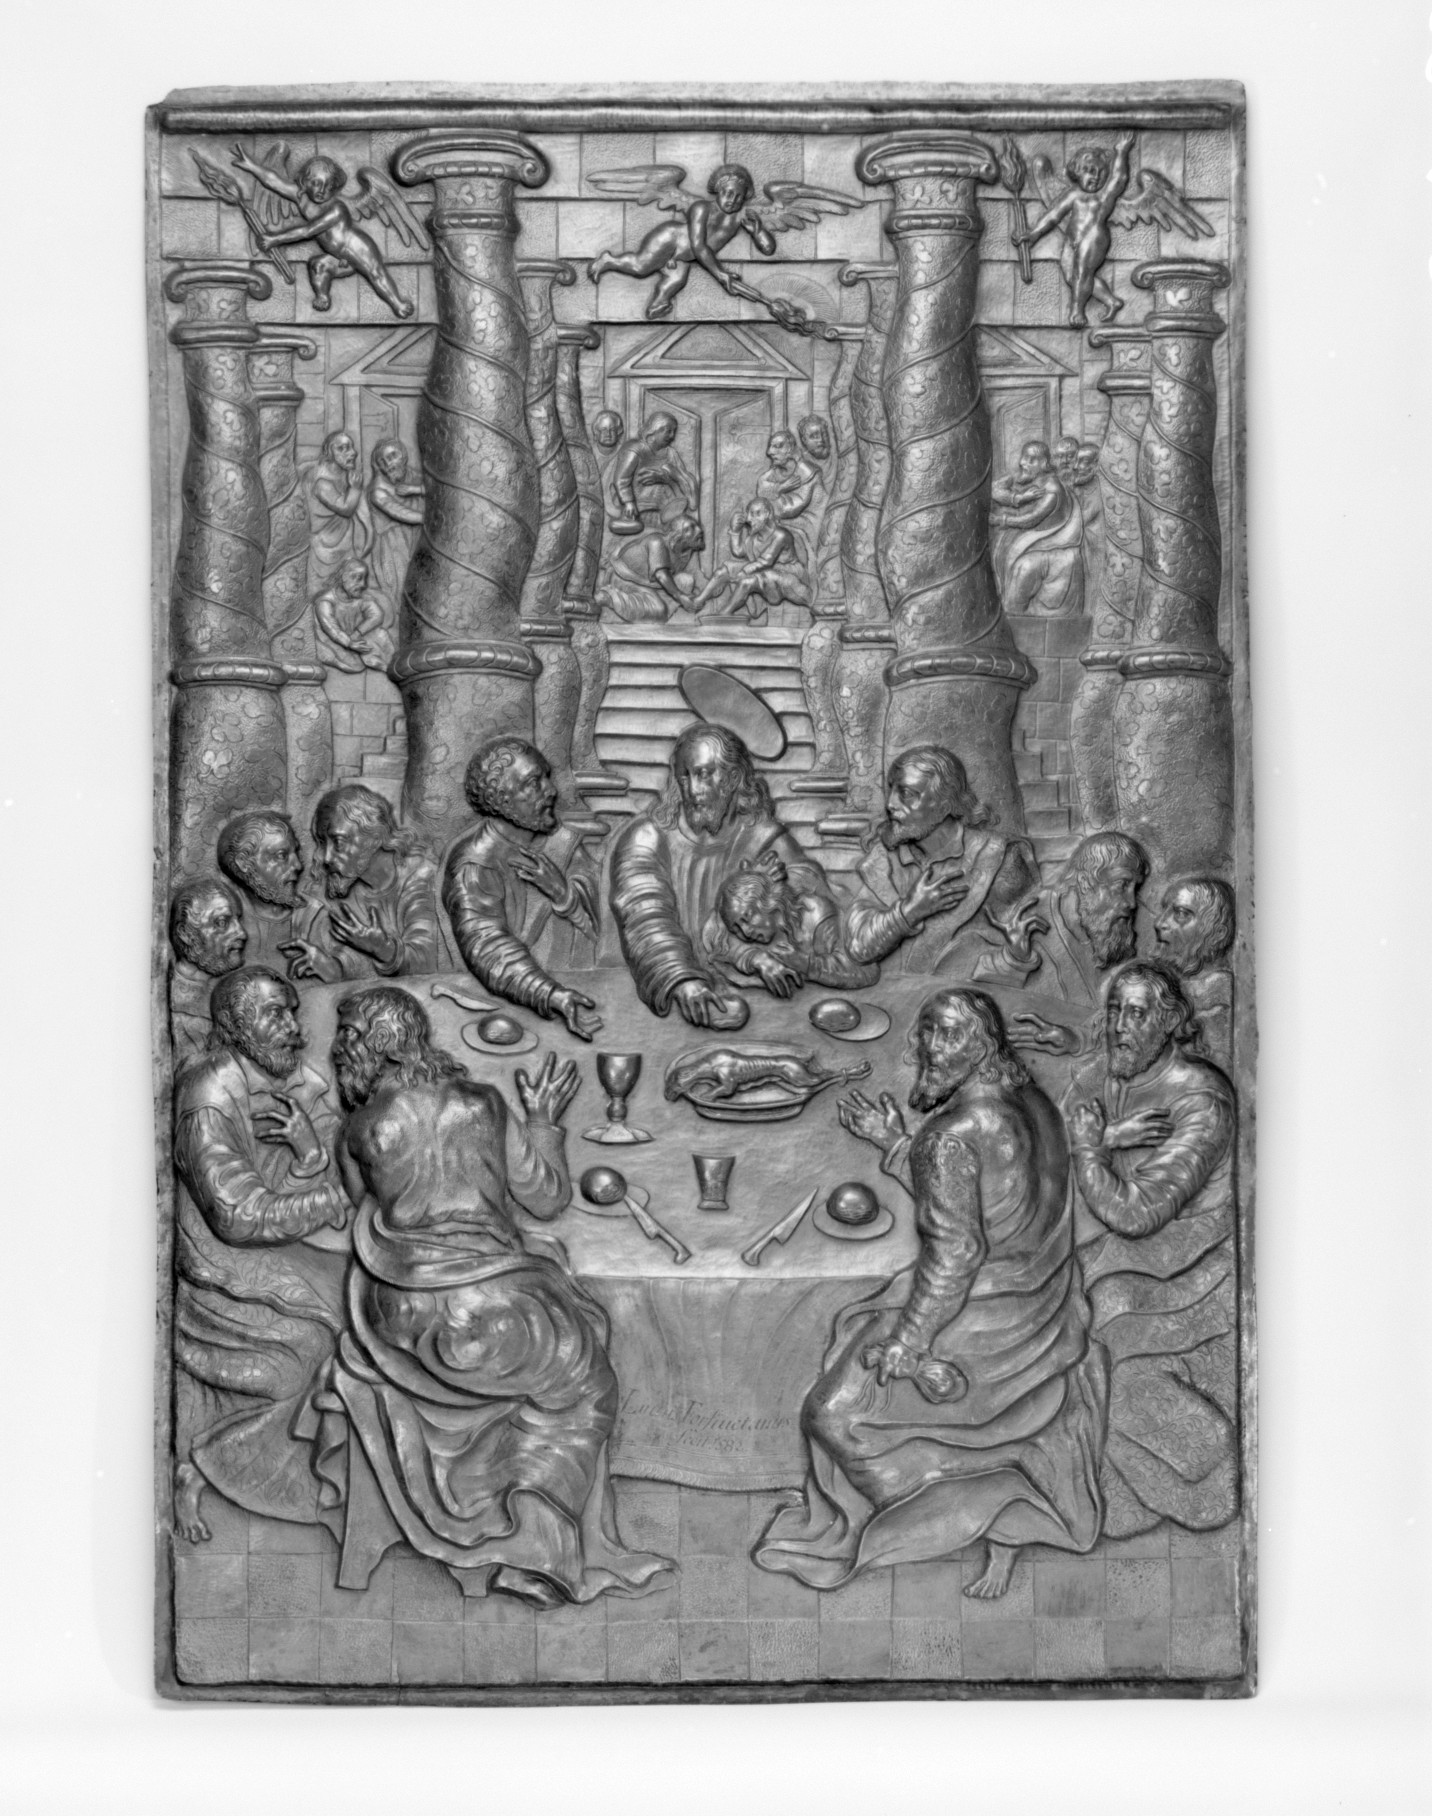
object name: relief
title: The Last Supper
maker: livio agresti da forlì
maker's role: artist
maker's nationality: italian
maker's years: 1550-1580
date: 1582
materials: copper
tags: last supper